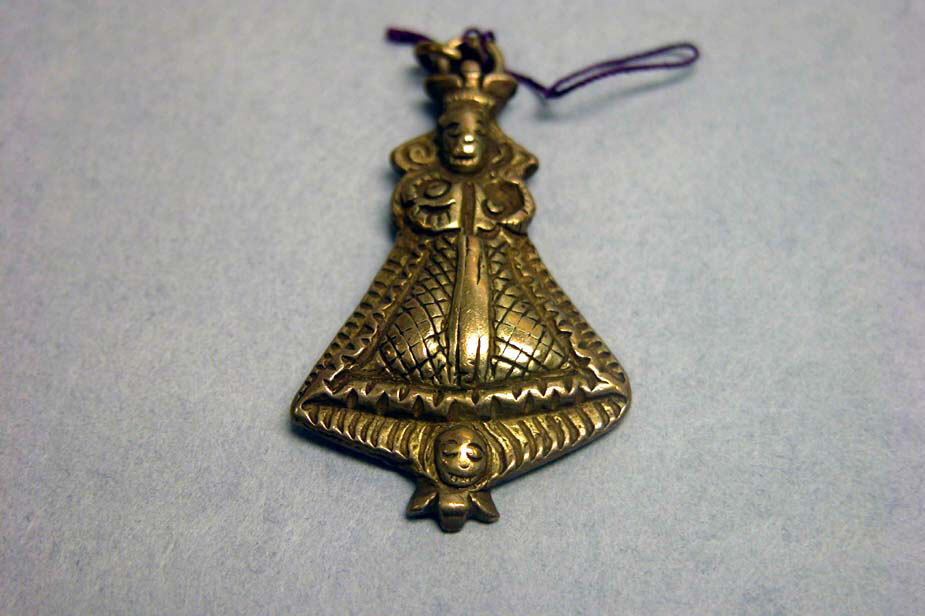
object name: pendant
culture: filipino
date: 1601-1900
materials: gold